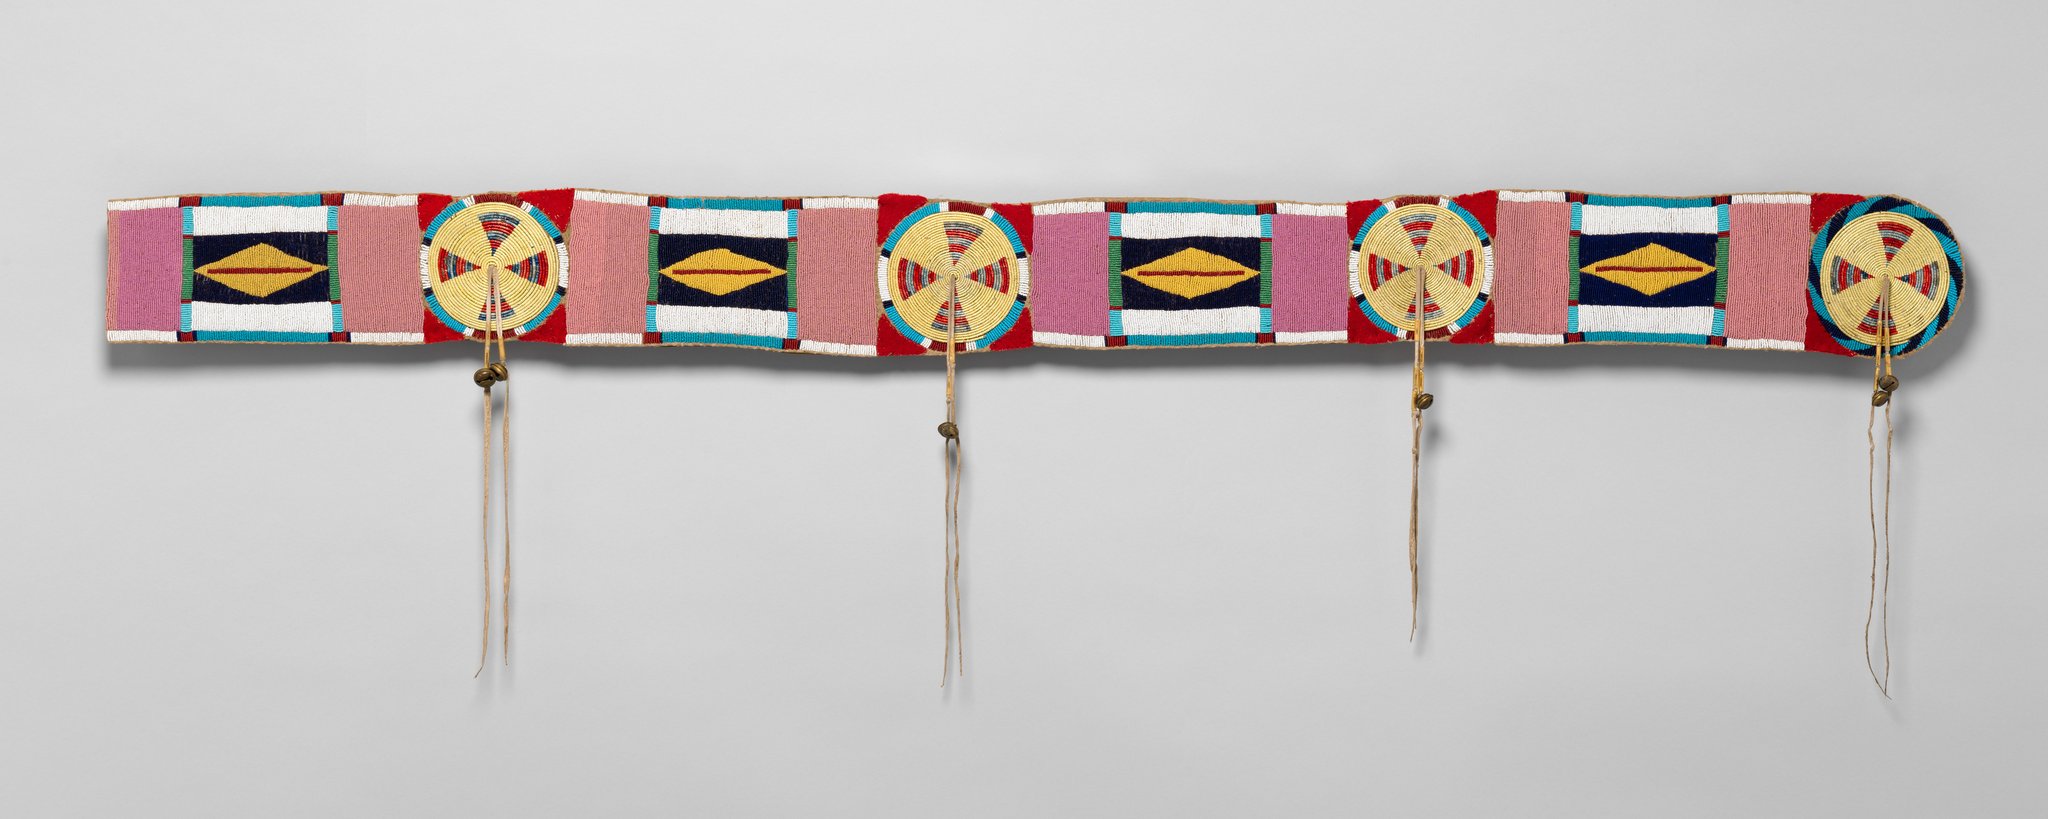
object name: blanket strip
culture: nez perce or niimíipuu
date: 1850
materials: brass, textile, dye, glass, hair, leather, wool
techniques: tanning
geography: united states